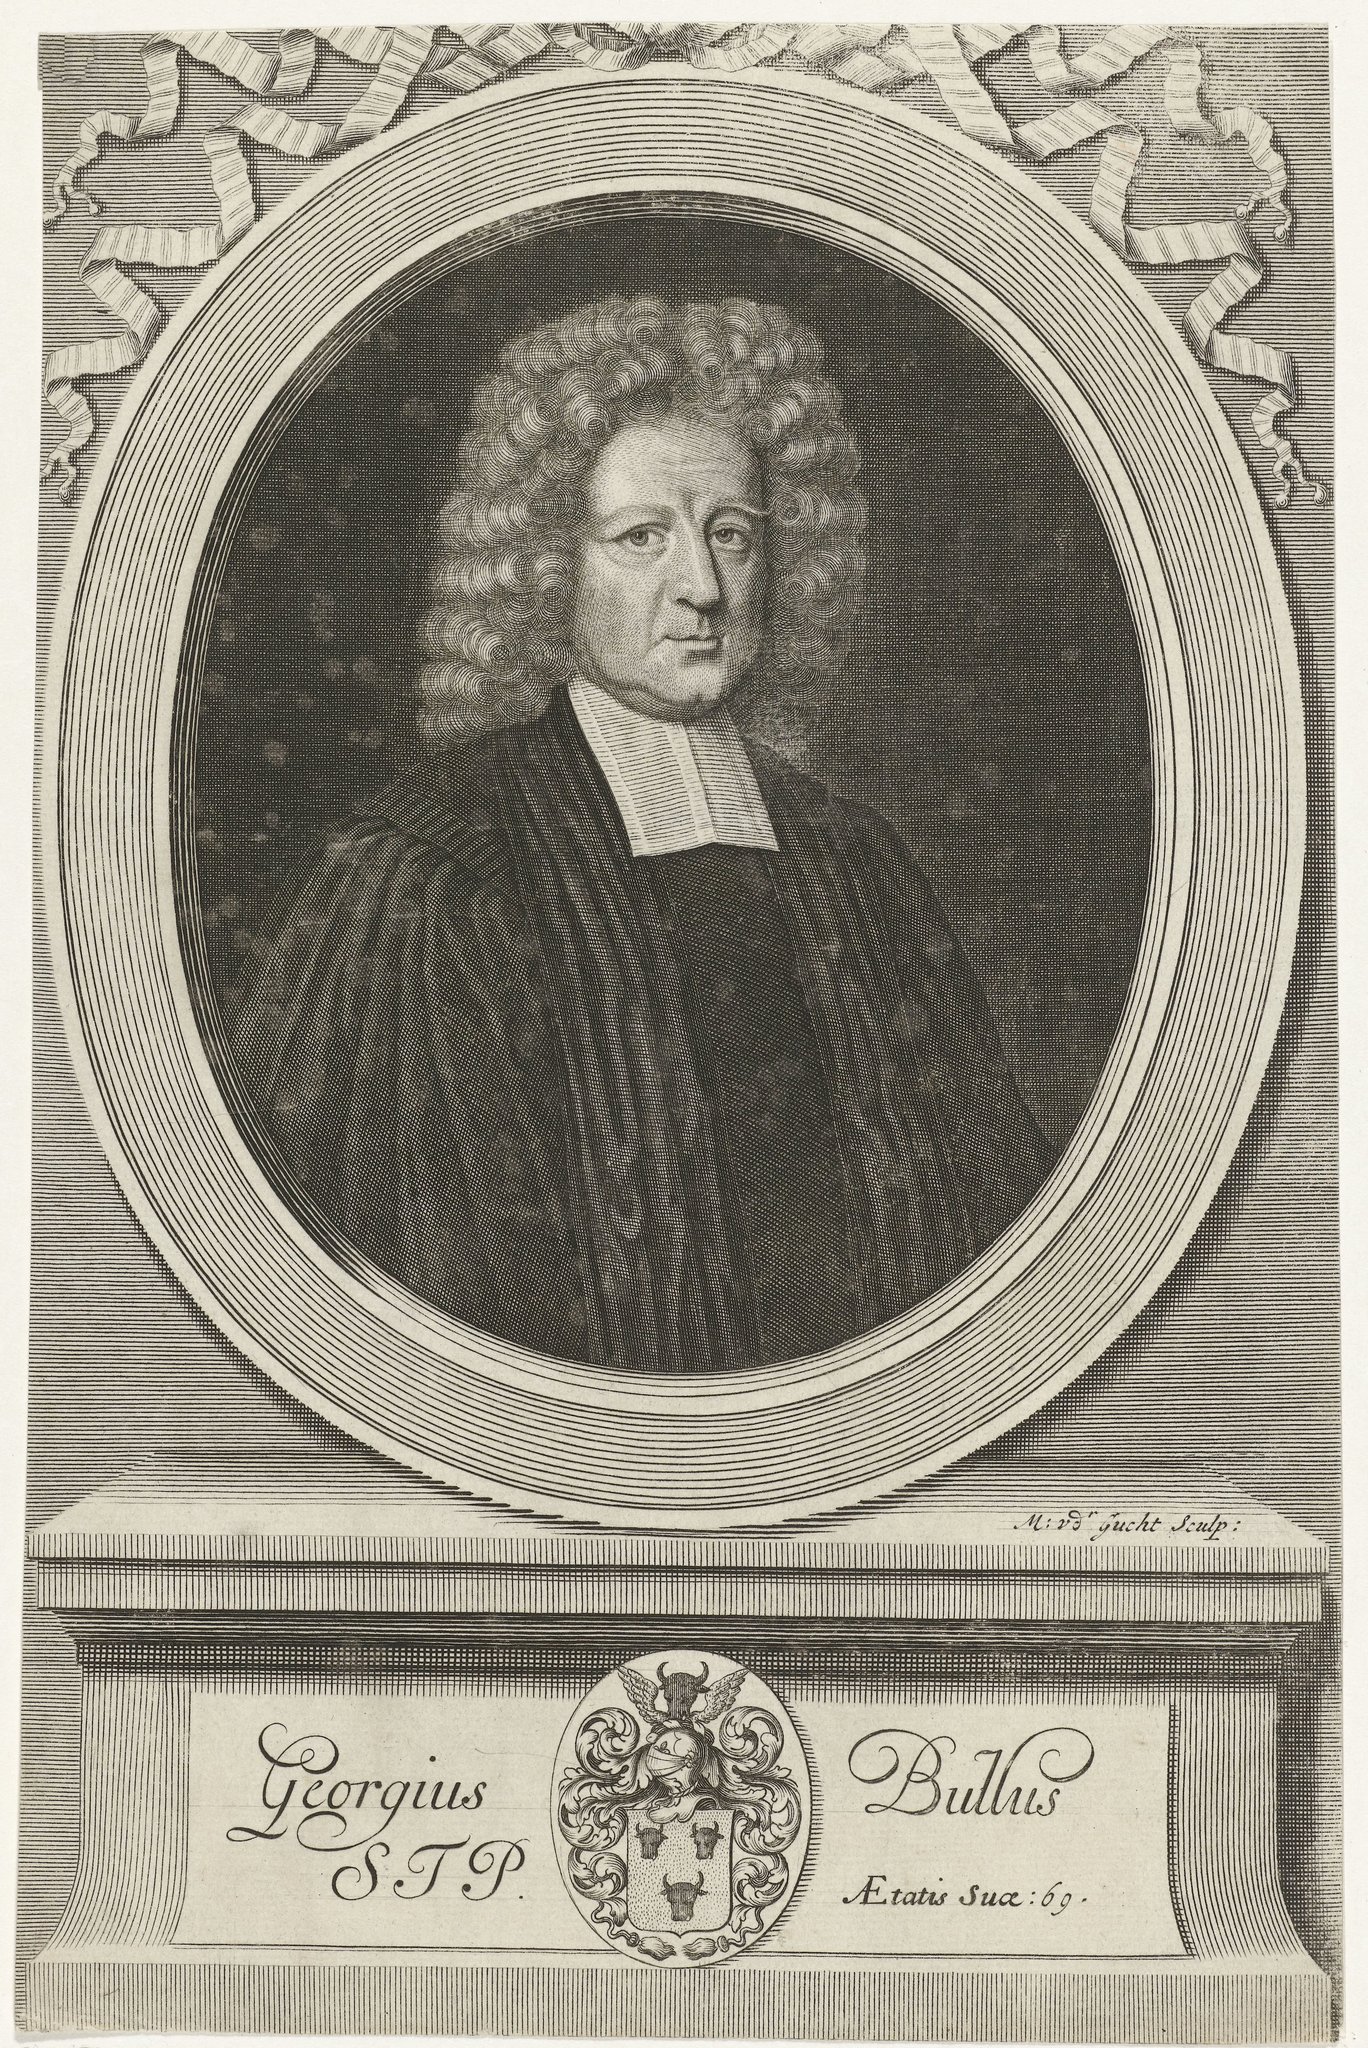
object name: book illustration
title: Portret van Georgius Bullus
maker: michiel van der gucht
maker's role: print maker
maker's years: 1660-1725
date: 1670-1725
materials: paper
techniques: engraving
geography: antwerp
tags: georgius bullus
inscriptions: collector's mark: Lugt 2228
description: Busteportret van Georgius Bullus, in toga. Het portret is gevat in een ovale omlijsting op een piëdestal. Onder de voorstelling in een kader het wapenschild, de naam en leeftijd van de geportretteerde. De prent fungeerde tevens als frontispiece in Bullus' Nuper Episcopi Menevensis (1721).